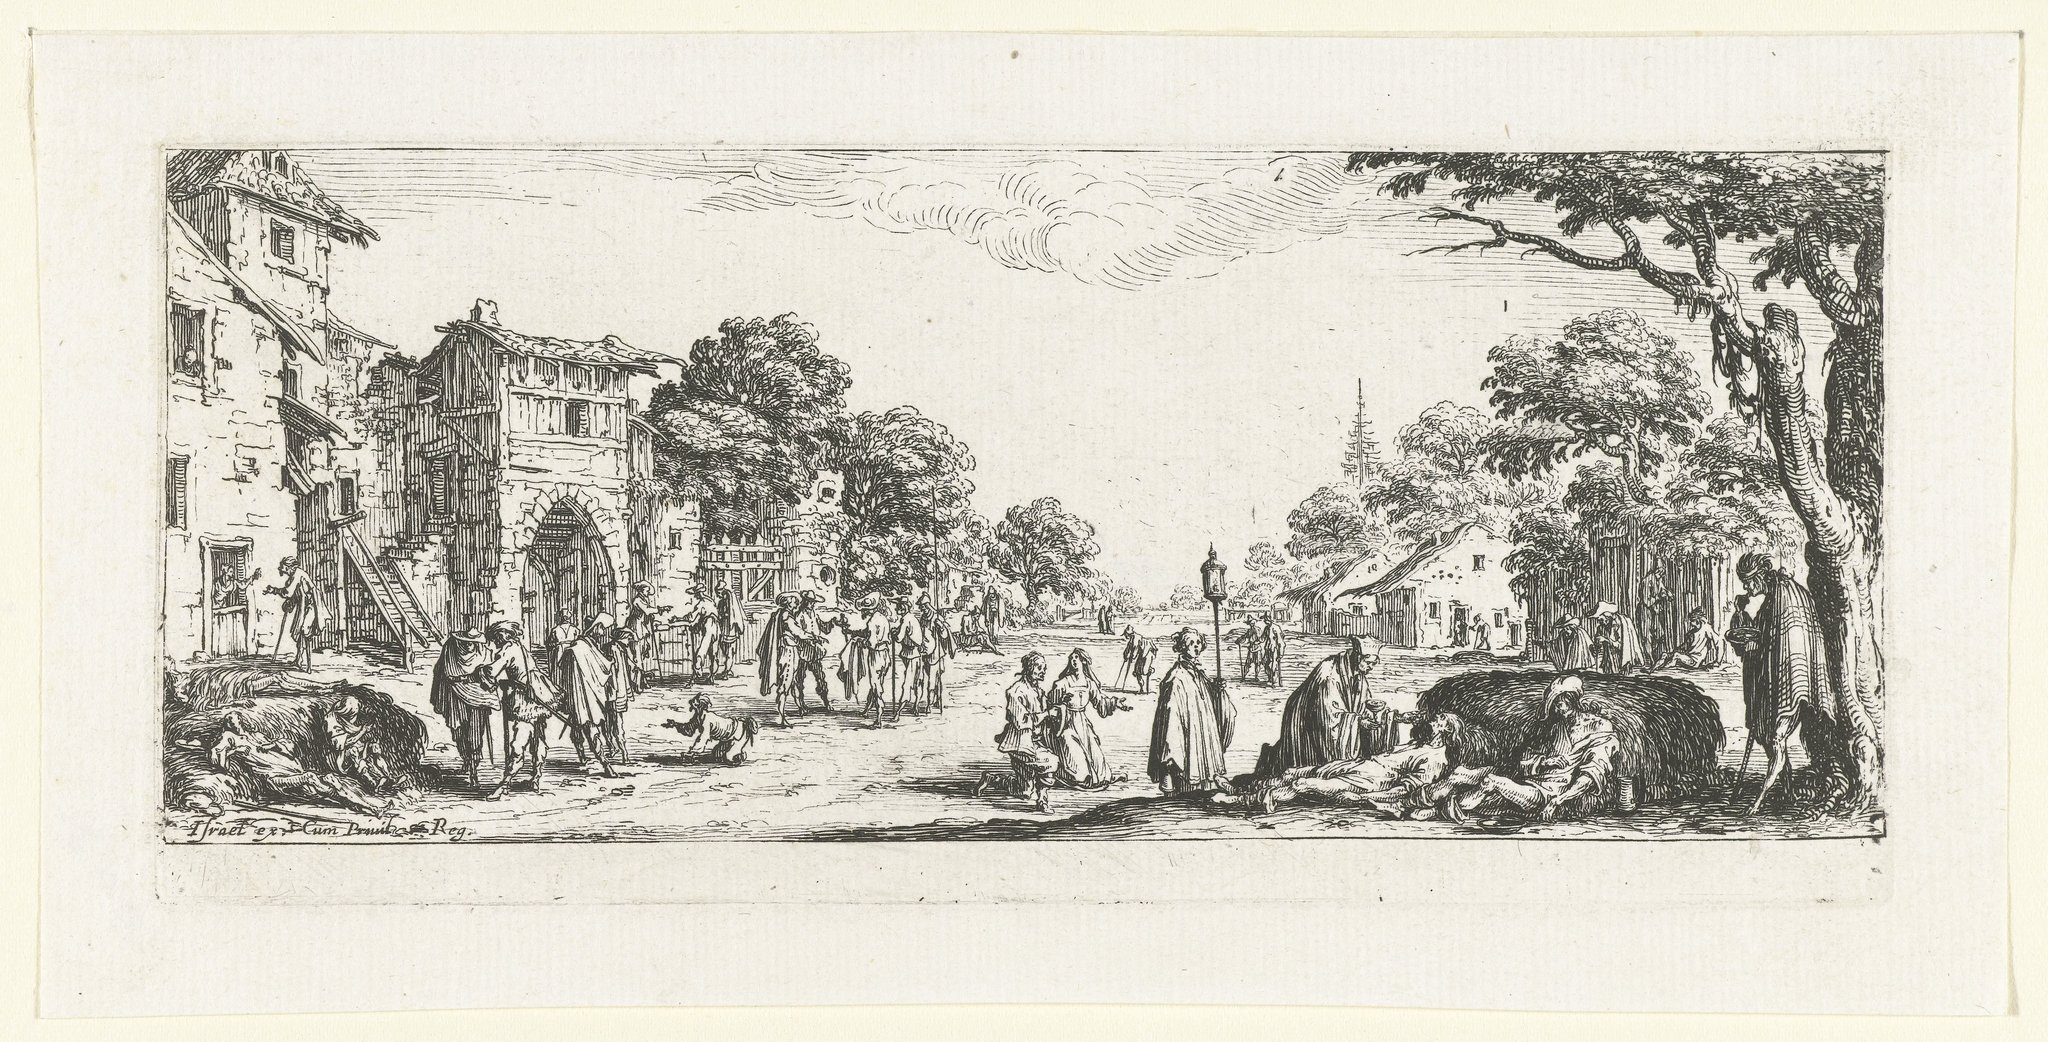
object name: print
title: De gruwelen van de oorlog (groot)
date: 1633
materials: paper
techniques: etching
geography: nancy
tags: deathbed, disabled soldier, beggar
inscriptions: collector's mark: Lugt 240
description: Op een weg omzoomd door huizen lopen en strompelen verarmde soldaten en oorlogsslachtoffers. Zij bedelen bij de dorpsbewoners om een aalmoes. Op de voorgrond links en rechts liggen enkelen uitgeput tegen balen hooi. Rechts staat een geestelijke een stervende bij. Onder de voorstelling een lege marge. Deze prent is onderdeel van een serie van 17 (18 incl. titelprent) prenten met voorstellingen van diverse soorten ellende die oorlogvoering met zich meebrengt.